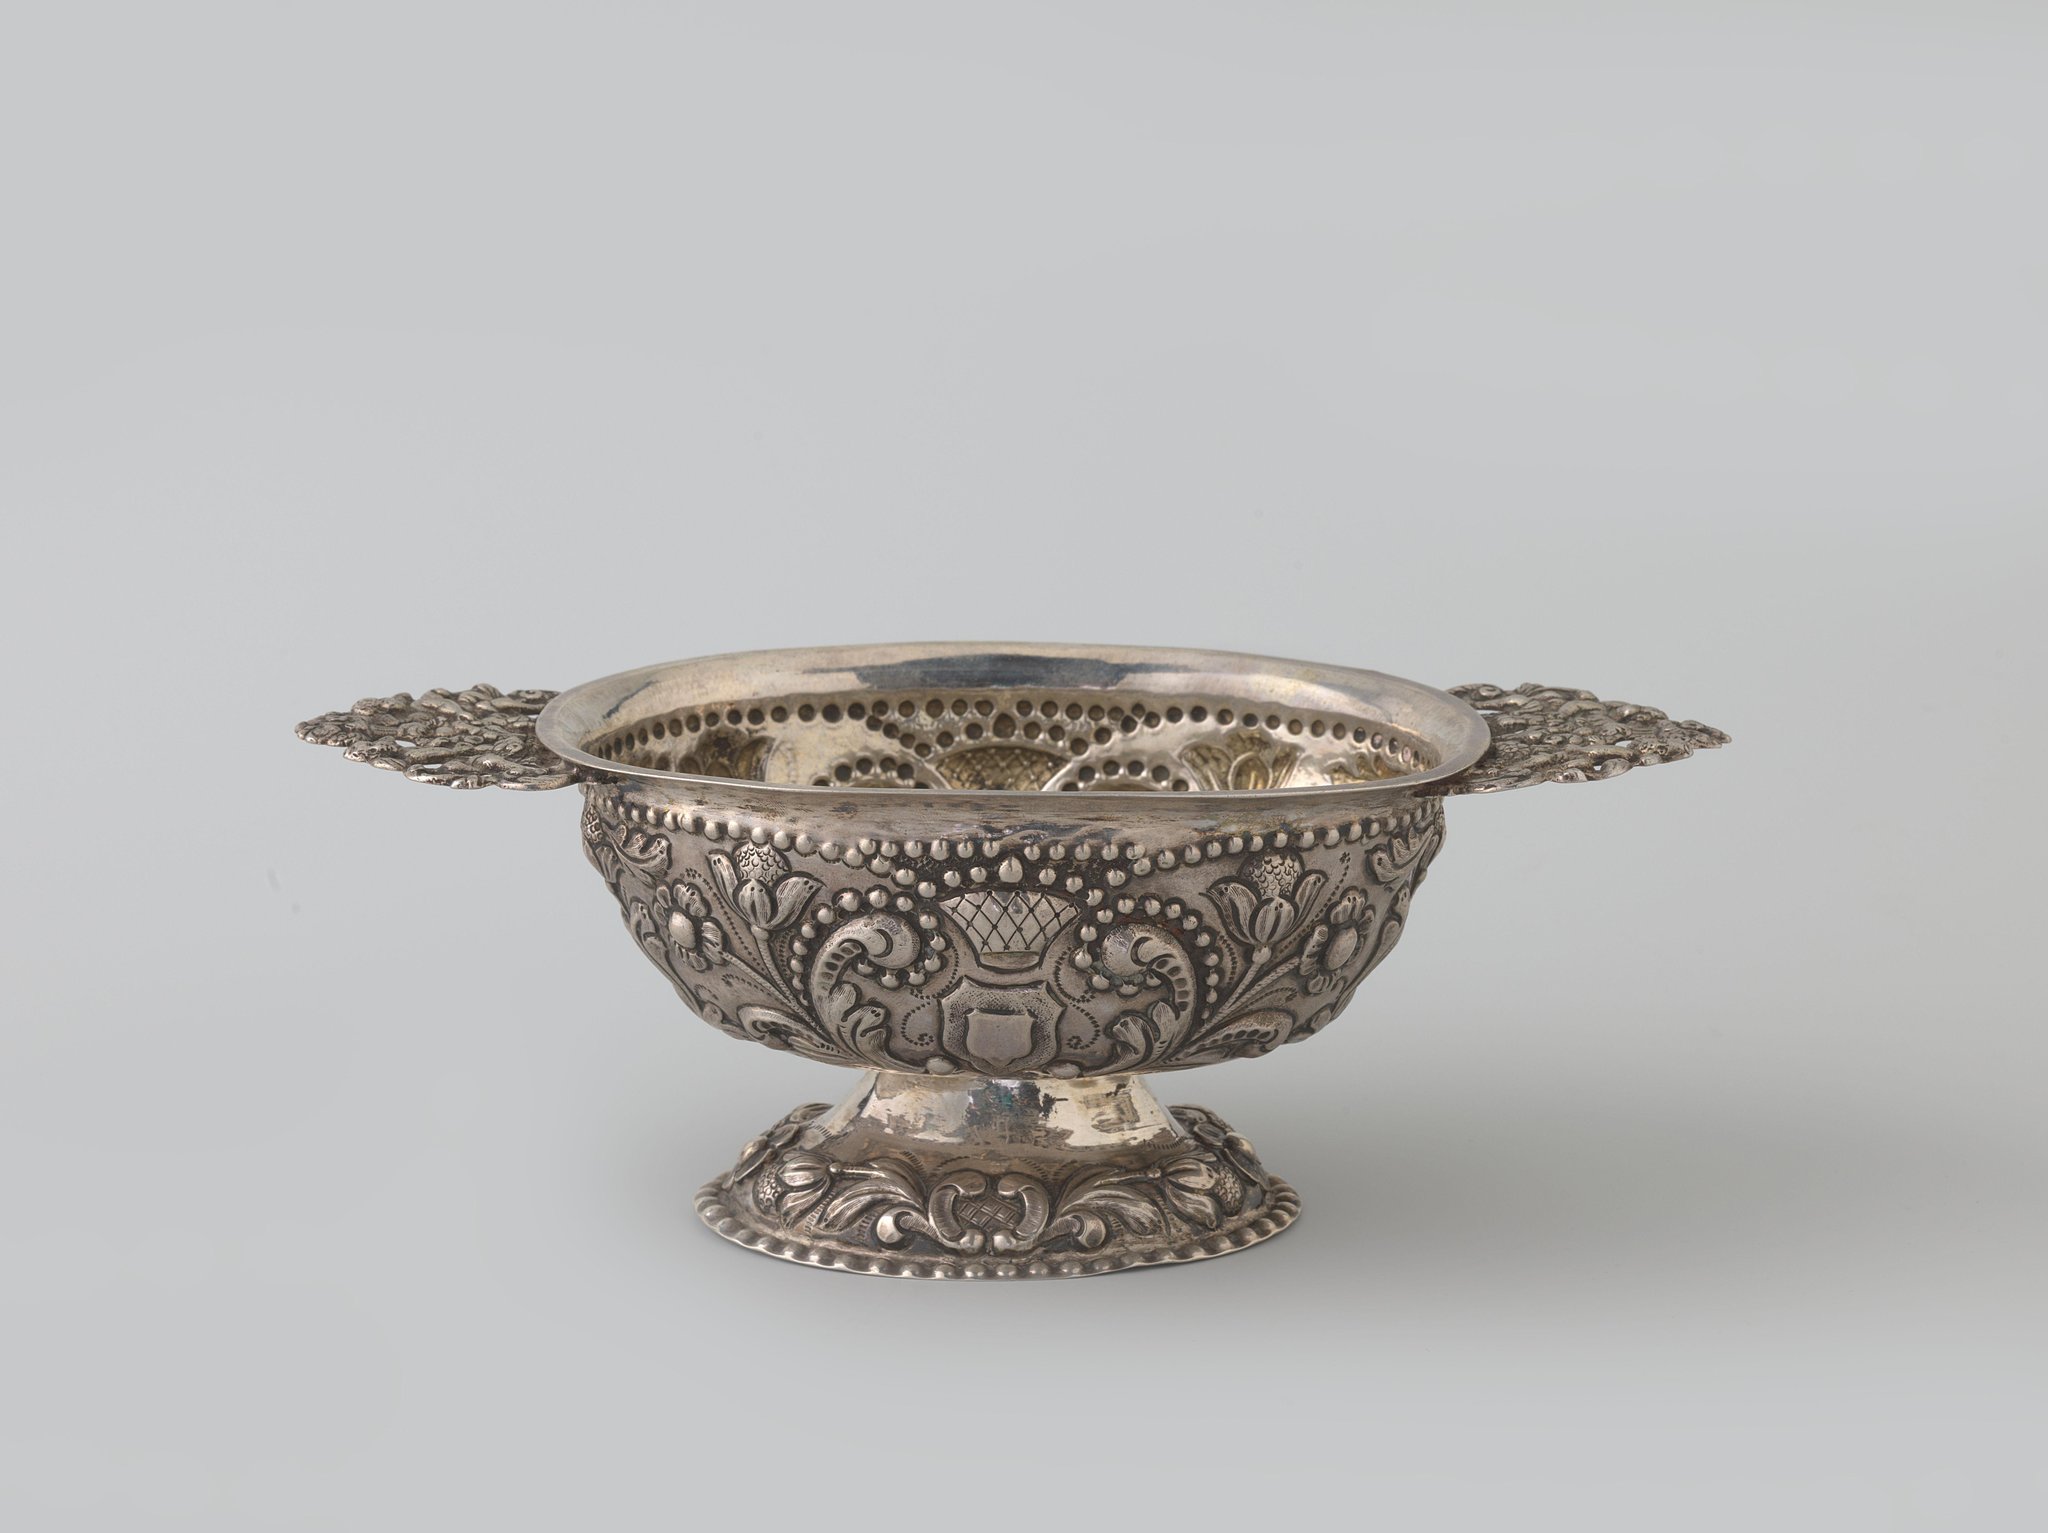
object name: drinking bowl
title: Brandewijnskom van gedreven zilver. Ovale cuppa op gewelfde voet. Opengewerkte horizontale oren. Vals.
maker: Anonymous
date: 1400-1950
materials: silver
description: Brandewijnkom van gedreven zilver. De ovale cuppa staat op een gewelfde voet. De gegoten horizontale oren zijn opengewerkt en vertonen een bloemenmand met engeltjes.